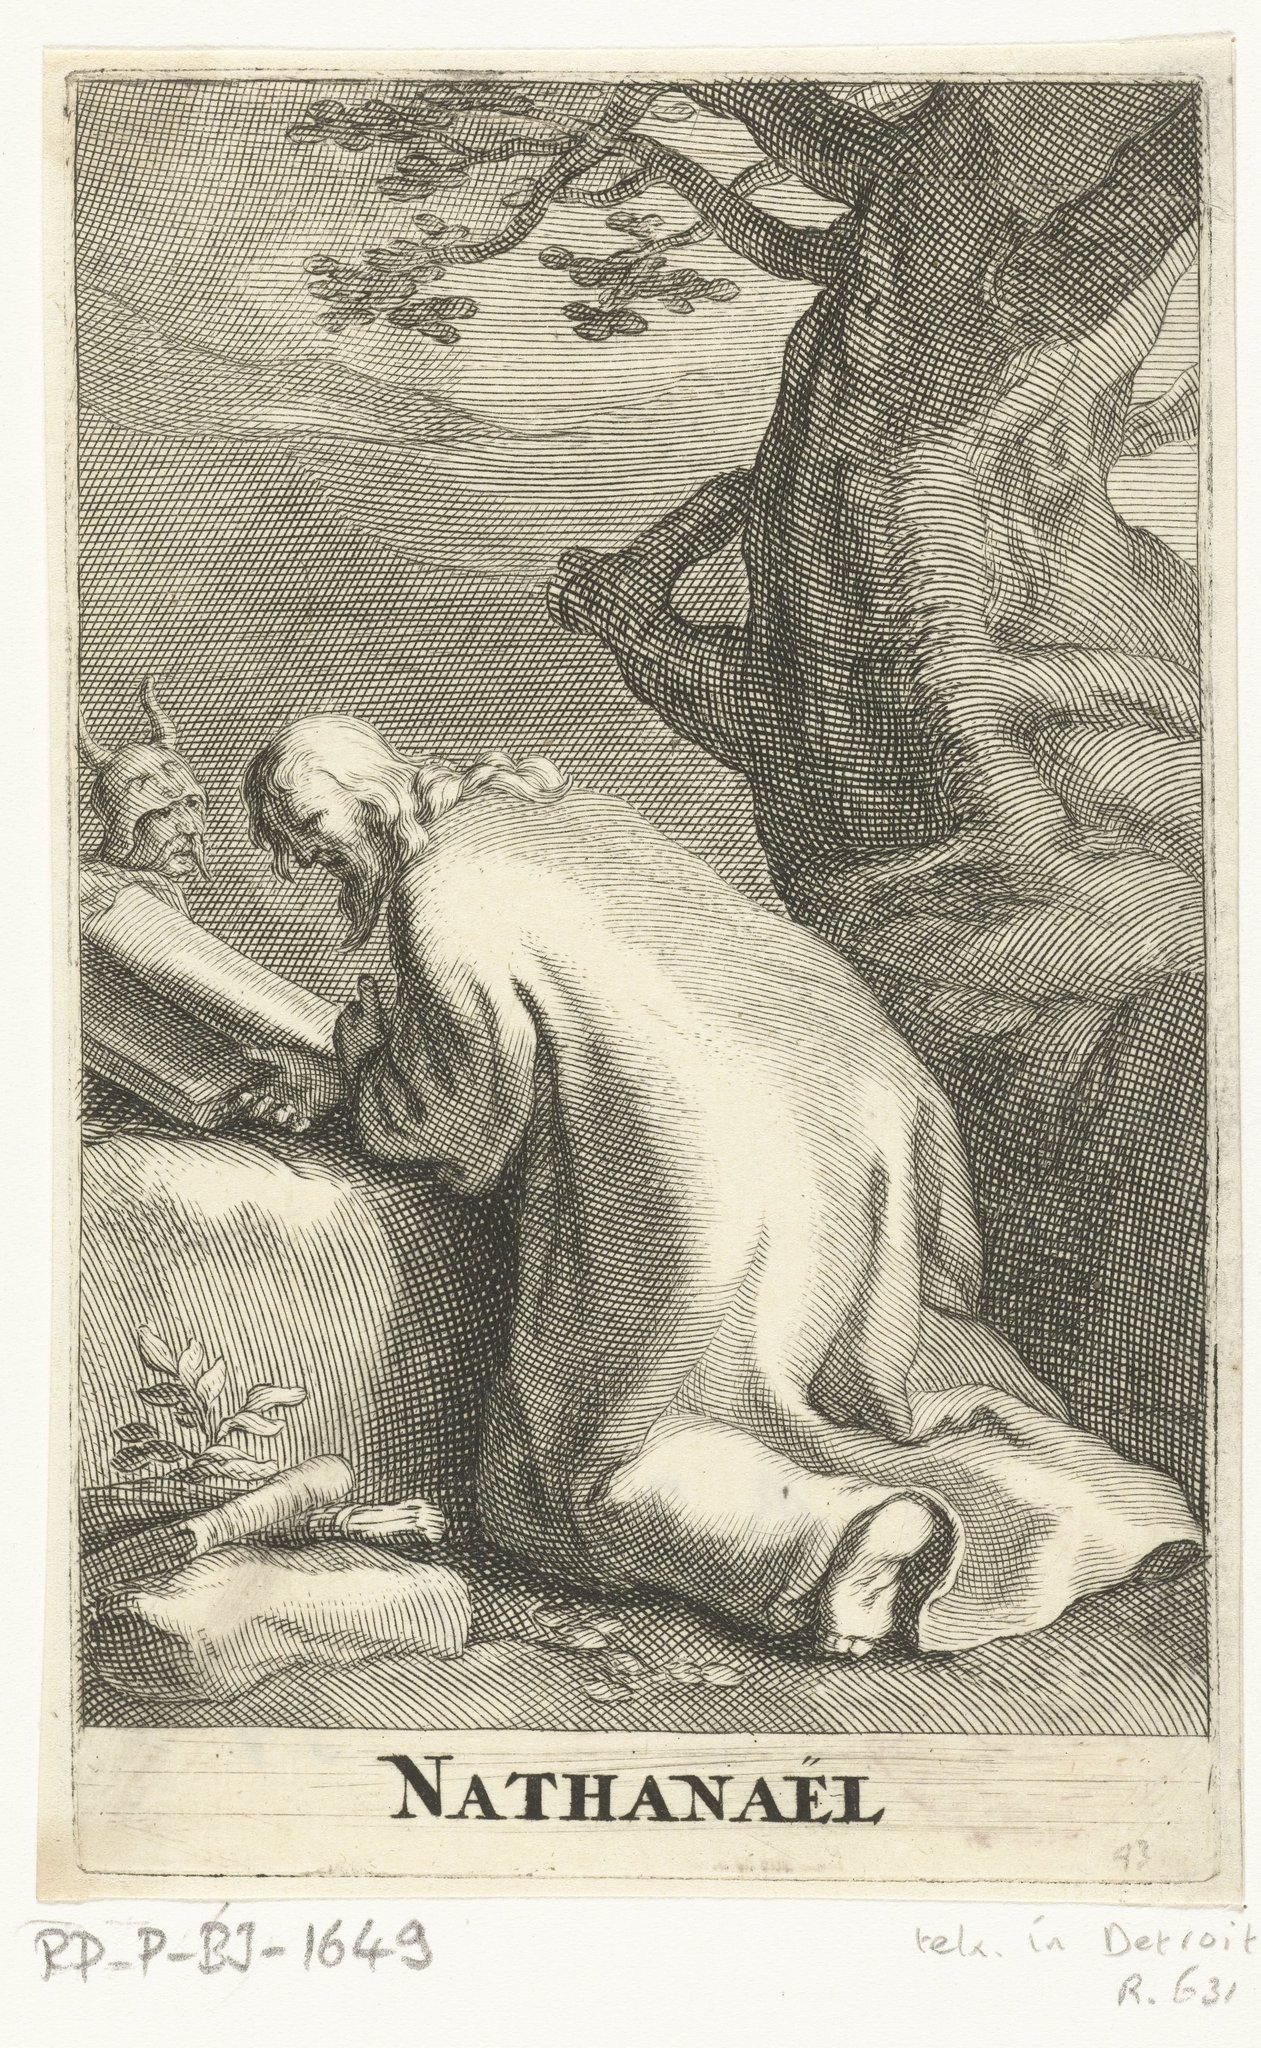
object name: print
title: Nathanaël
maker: frederick bloemaert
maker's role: print maker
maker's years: 1614-1669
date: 1636-1670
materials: paper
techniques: engraving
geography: utrecht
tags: male saints (with name), anchorite, hermit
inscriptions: collector's mark: Lugt 240, number: ‘53’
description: Als een 'atleet van Christus' wil de heilige Nathanaël de duivel verslaan die hem verschenen is als een krijgsman. Prent uit een serie van 80 prenten en een titelprent met kluizenaars uit de 2e tot de 6e eeuw.